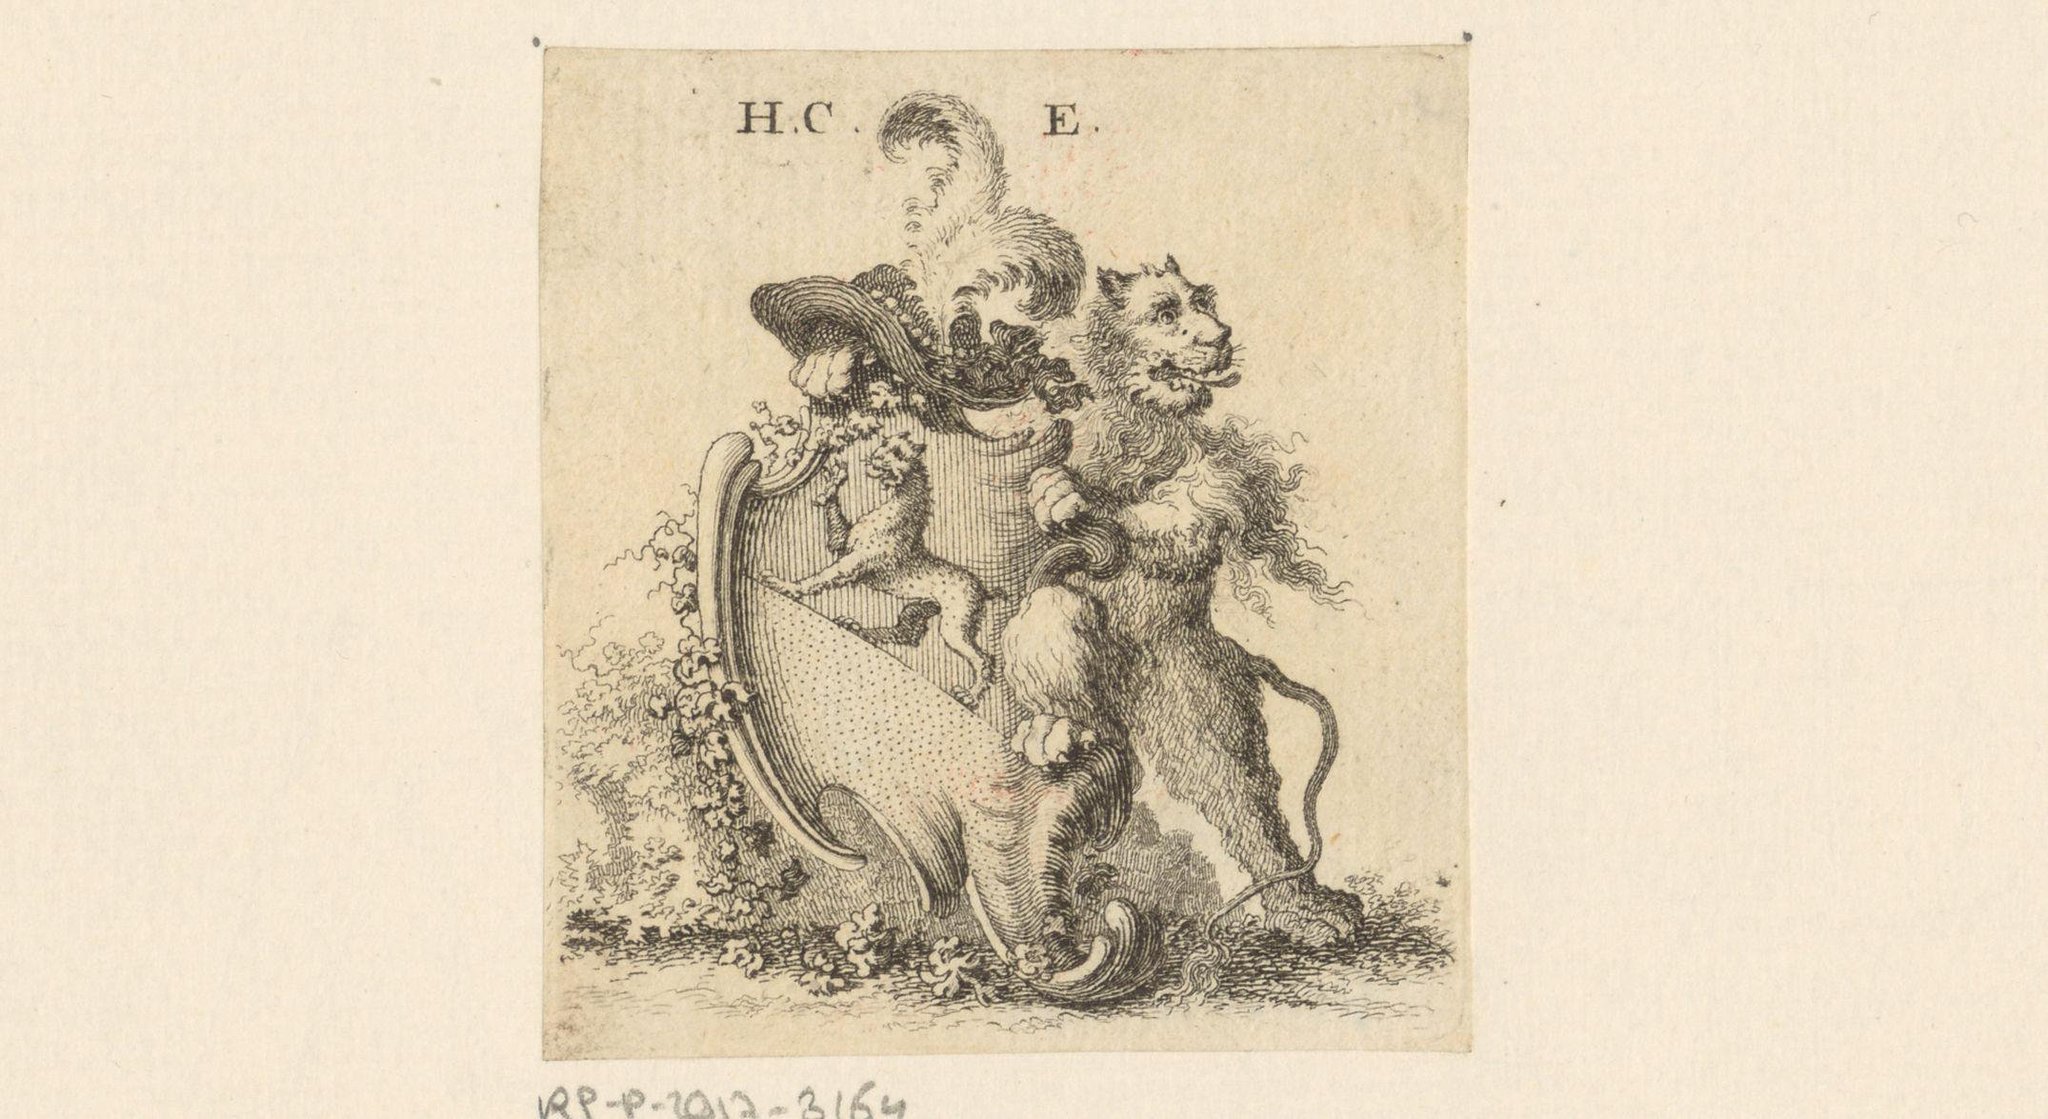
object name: bookplate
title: Ex libris van Hans Conrad Escher vom Luchs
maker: Anonymous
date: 1753-1814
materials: paper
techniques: etching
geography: switzerland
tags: head-gear: hat, beasts of prey, predatory animals: lion, armorial bearing, heraldry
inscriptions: inscription: ‘Escher vom Luchs / Gerster 628’